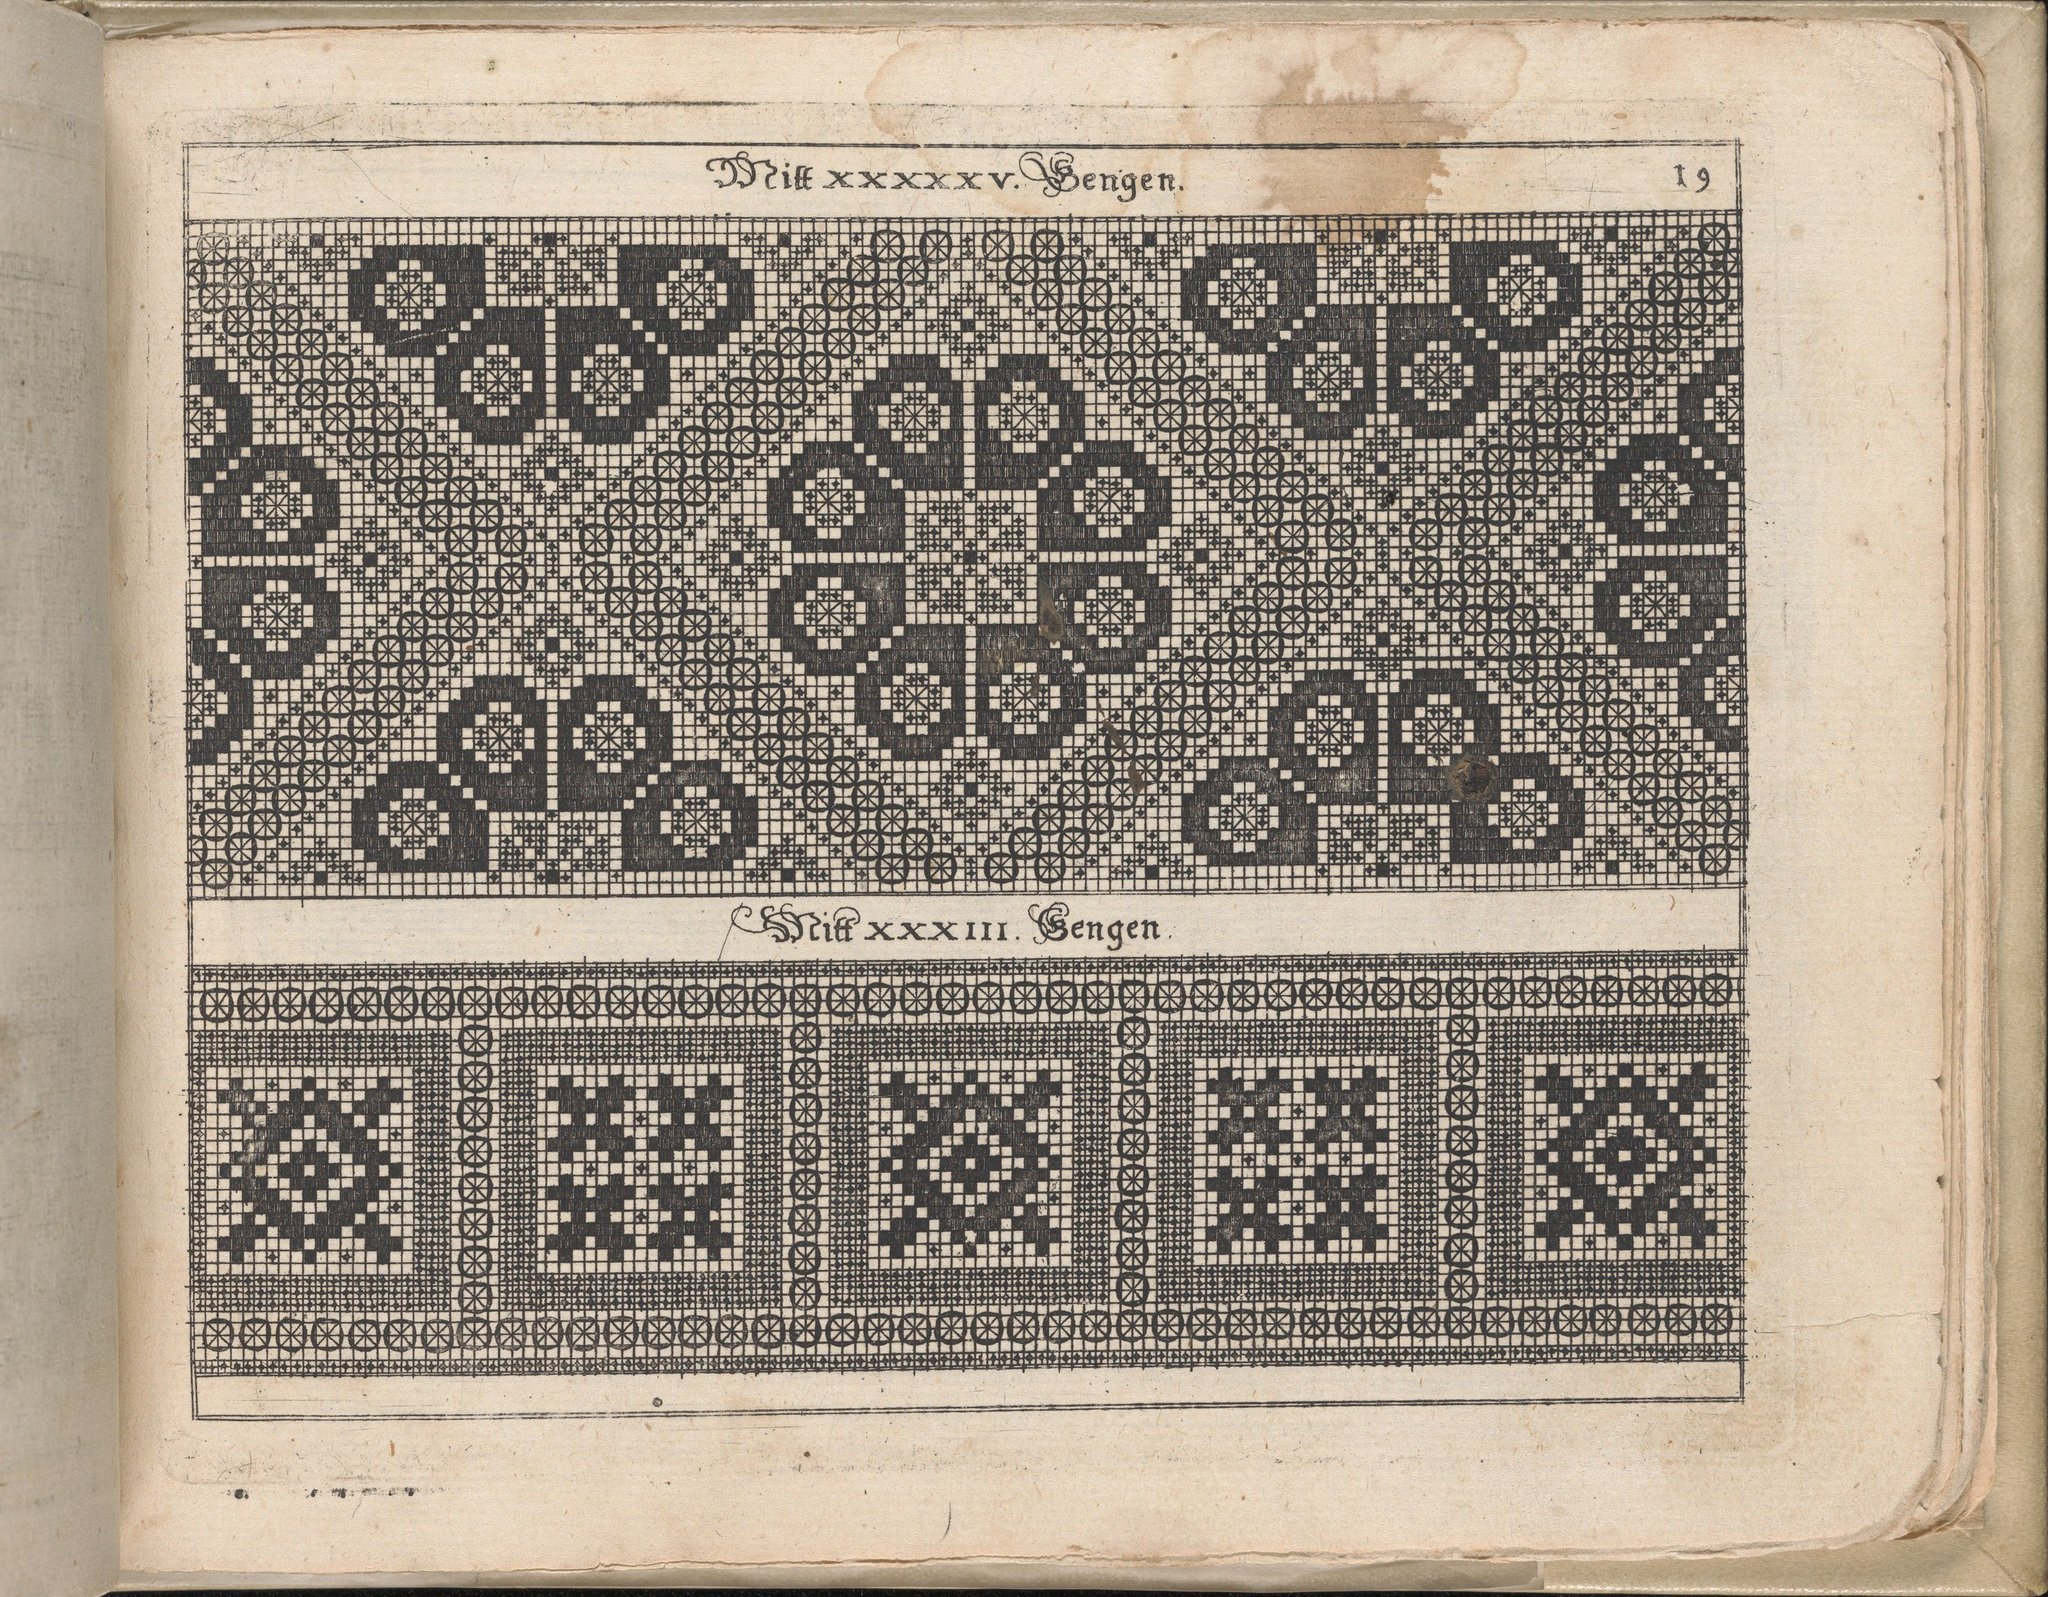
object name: book print ornament architecture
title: Schön Neues Modelbuch (Page 24 recto)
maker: johann sibmacher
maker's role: designer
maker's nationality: german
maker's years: 1590-1611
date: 1597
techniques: etching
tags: ornament